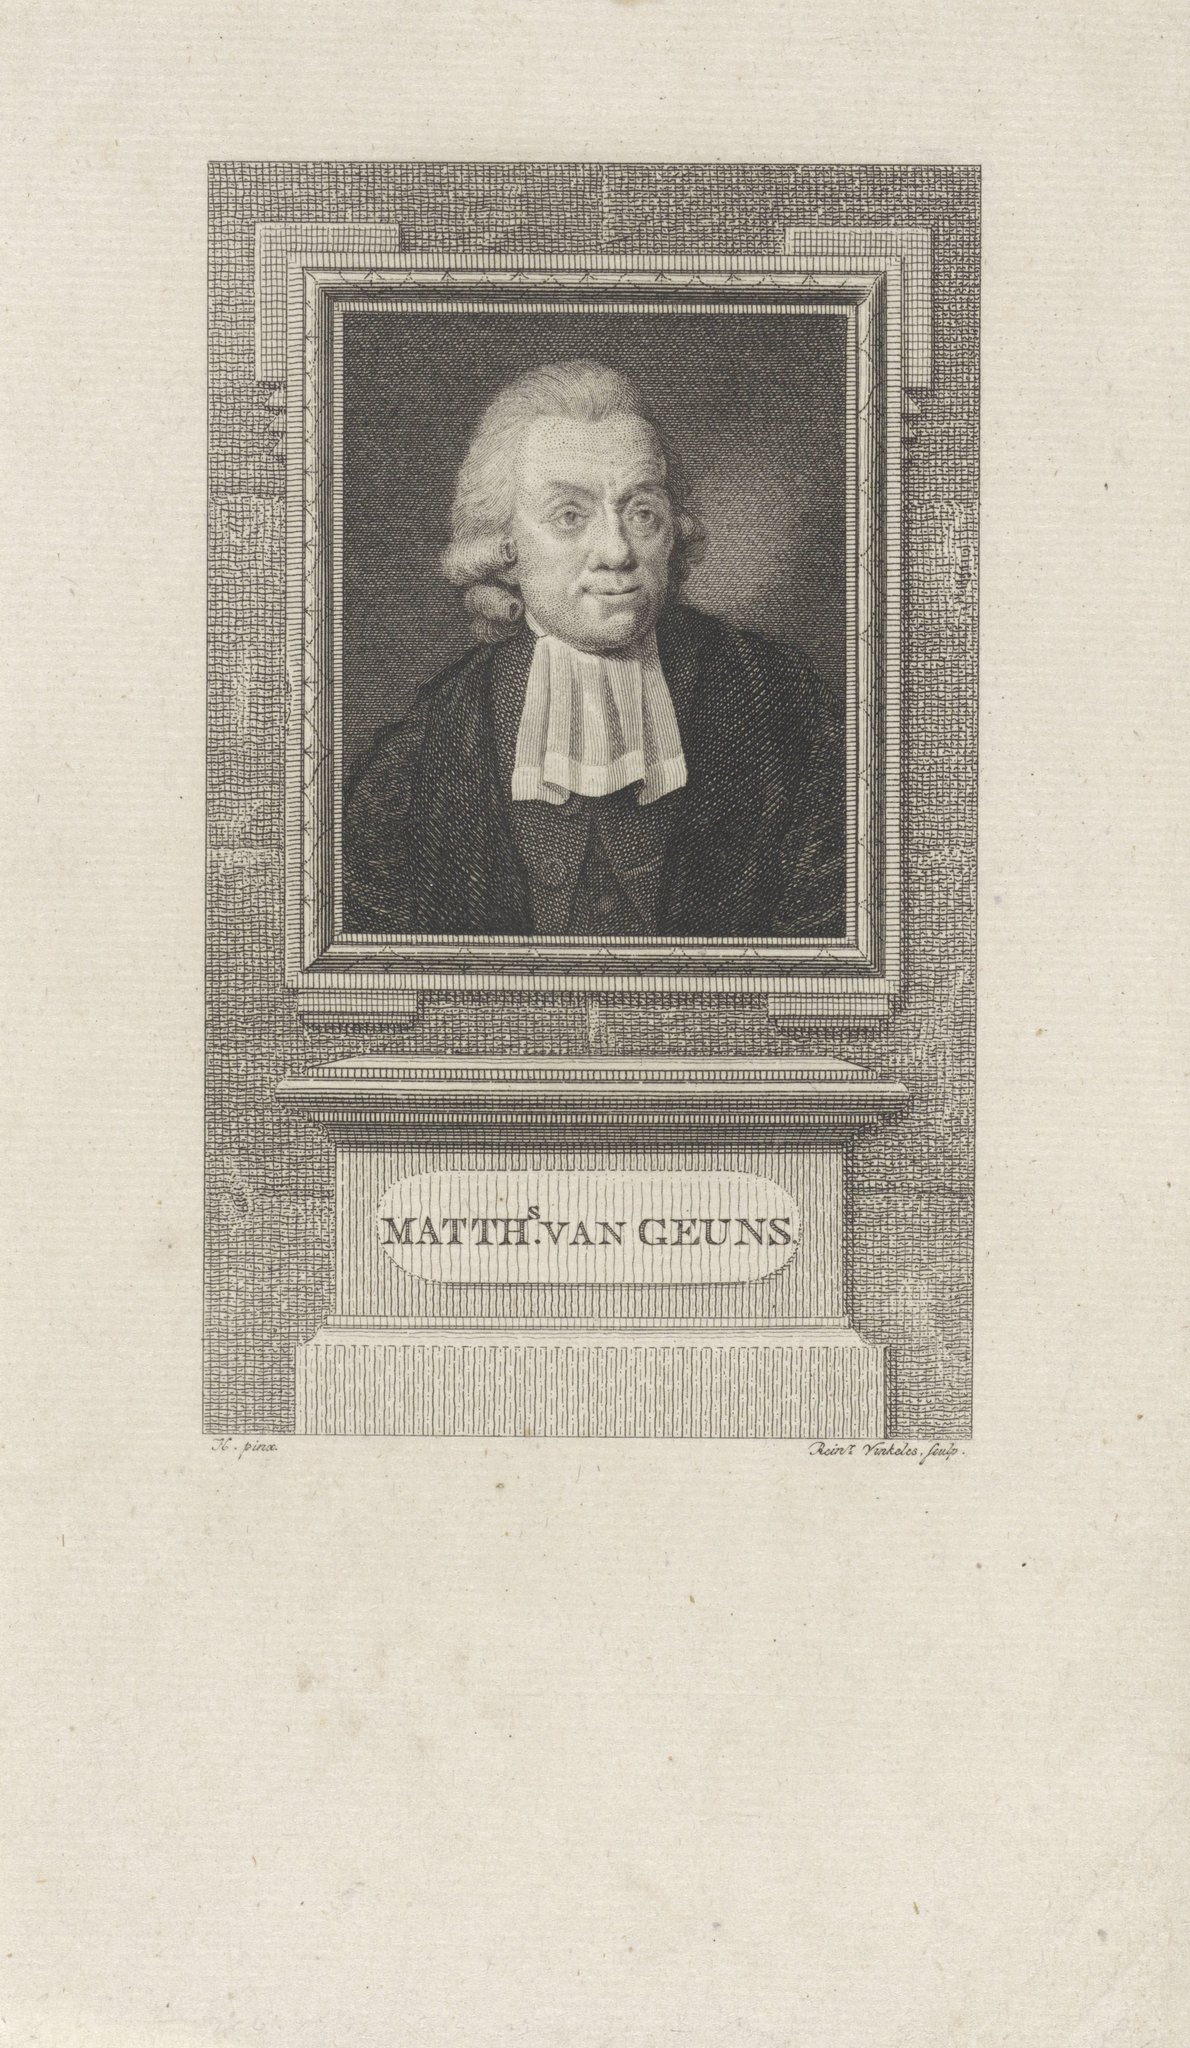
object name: print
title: Portret van Matthias van Geuns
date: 1786-1809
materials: paper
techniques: engraving, etching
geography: amsterdam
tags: geneeskundige, matthias van geuns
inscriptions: collector's mark: Lugt 2228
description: Prent ook gebruikt als boekillustratie in: Wagenaar, Jan. Vaderlandsche historie, (...) ten vervolge van Wagenaars Vaderlandsche historie. Dl. 1-43. Amsterdam: Johannes Allart, 1786-1809.